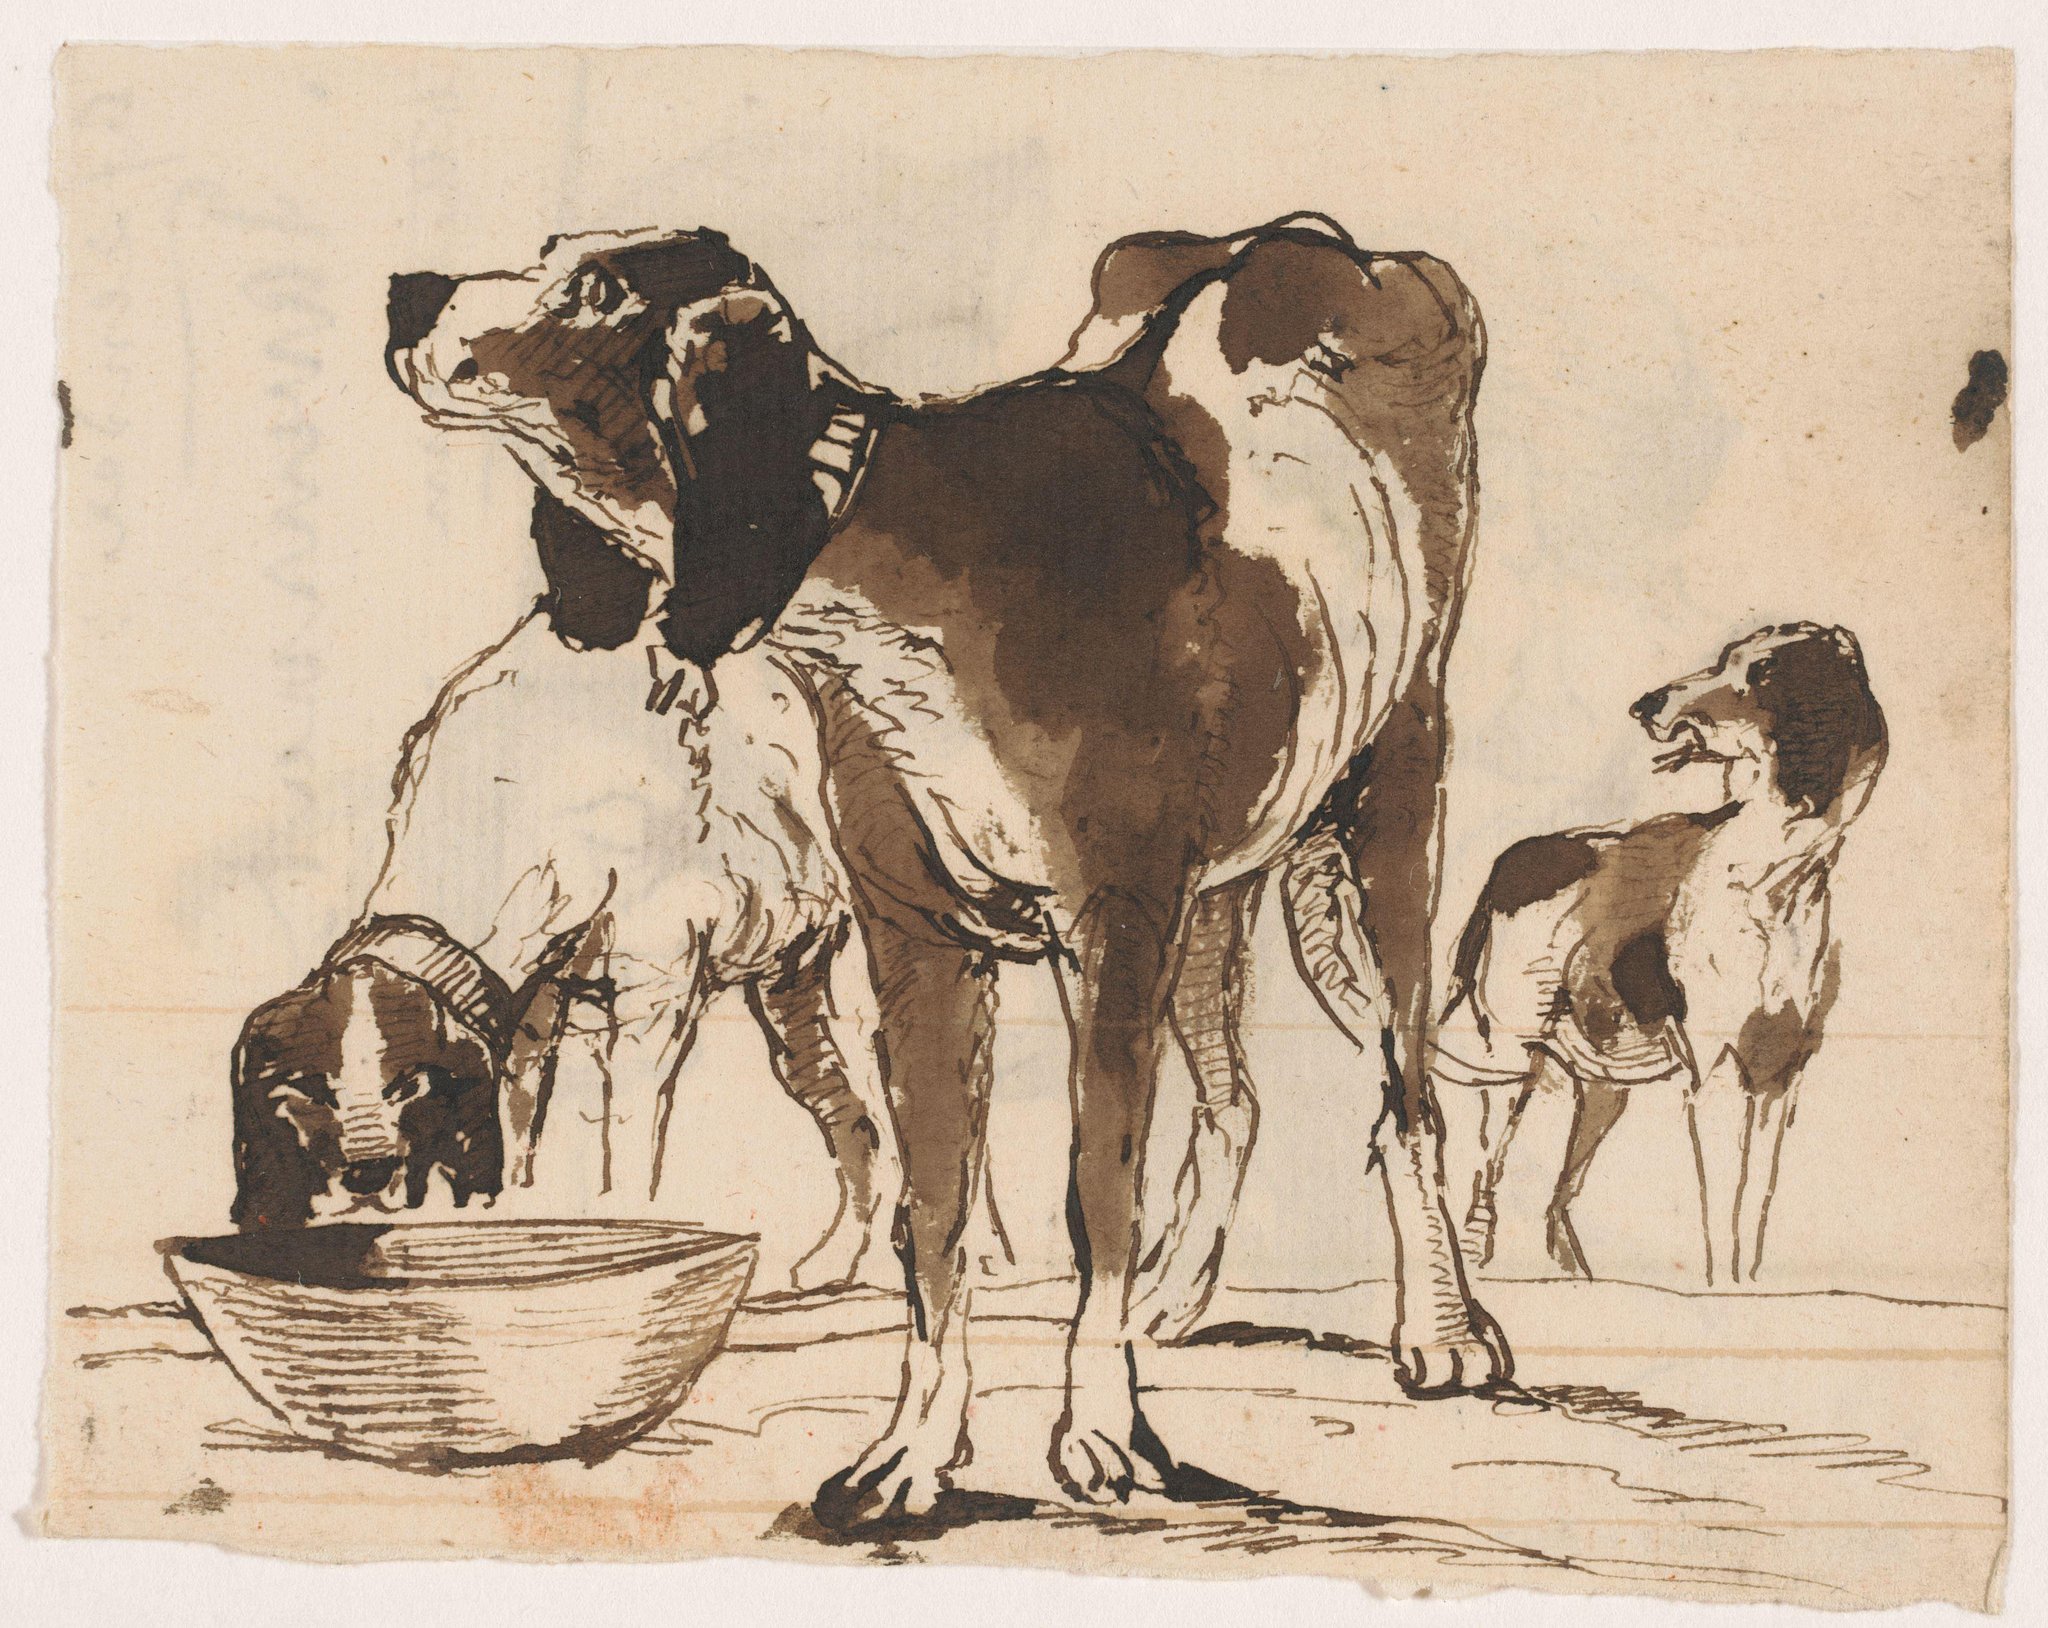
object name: drawing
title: Jachthonden met drinkbak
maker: johannes tavenraat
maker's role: draughtsman, painter, print maker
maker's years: 1809-1881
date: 1840-1880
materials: ink, paper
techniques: brush, pen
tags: hunting dogs, dog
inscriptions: collector's mark: Lugt 2228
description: Jachthonden met drink- of etensbak. Getekend op de achterzijde van een deel van een envelop of brief met J. Tavenraat als afzender.